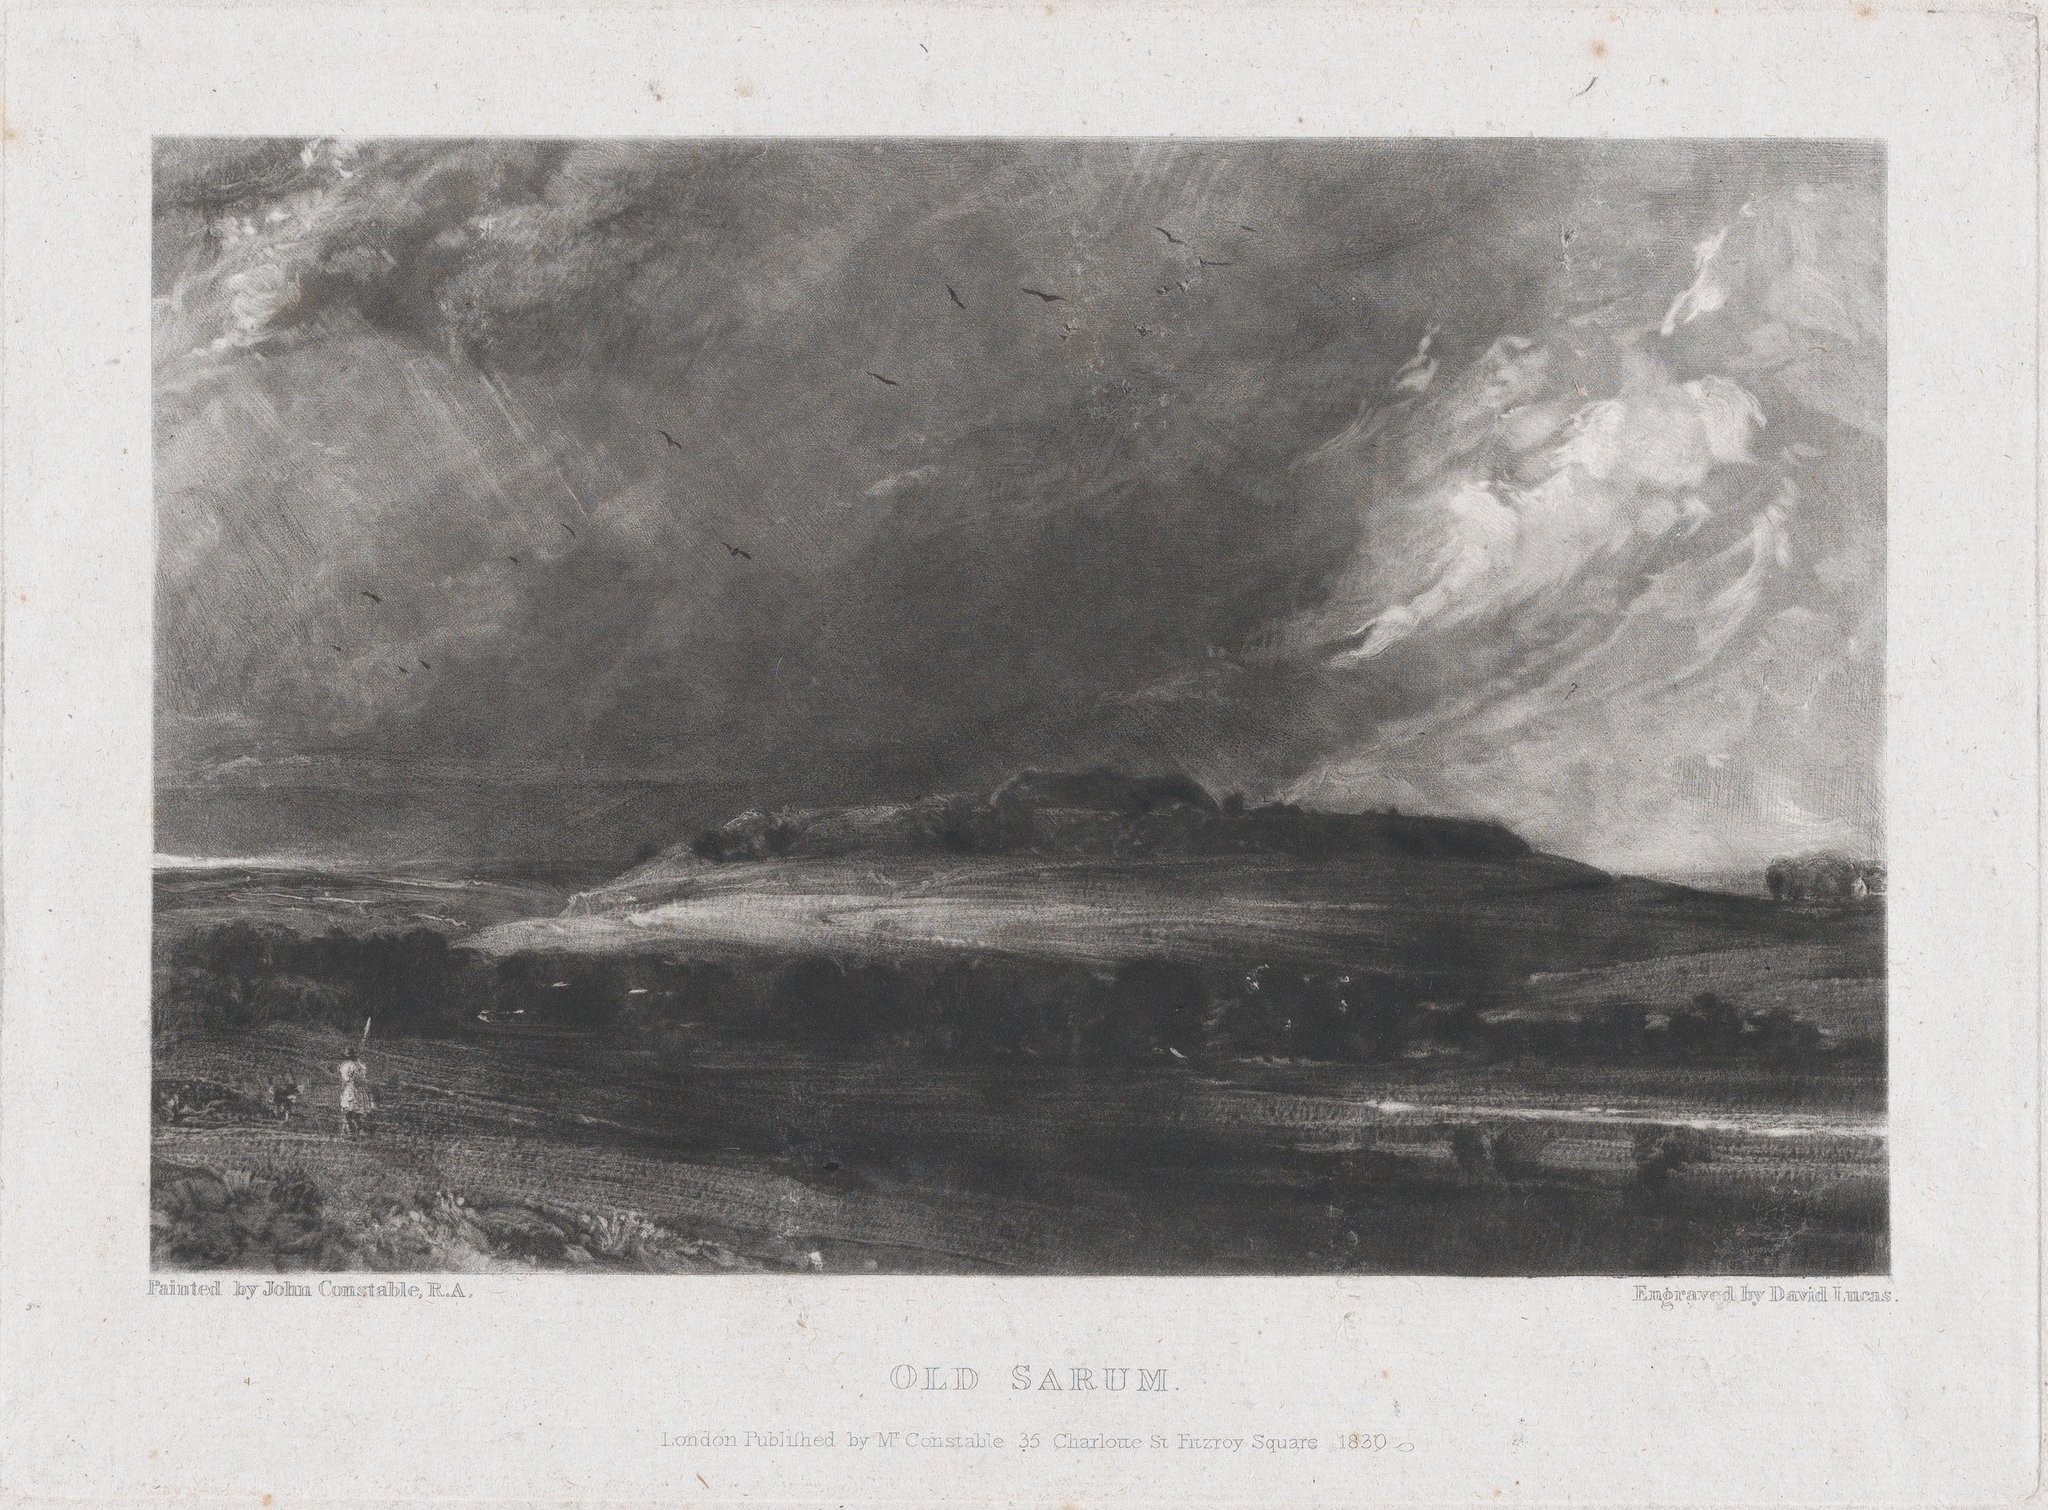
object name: print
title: Old Sarum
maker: david lucas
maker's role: artist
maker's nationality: british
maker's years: 1802-1881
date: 1830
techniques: mezzotint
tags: landscapes